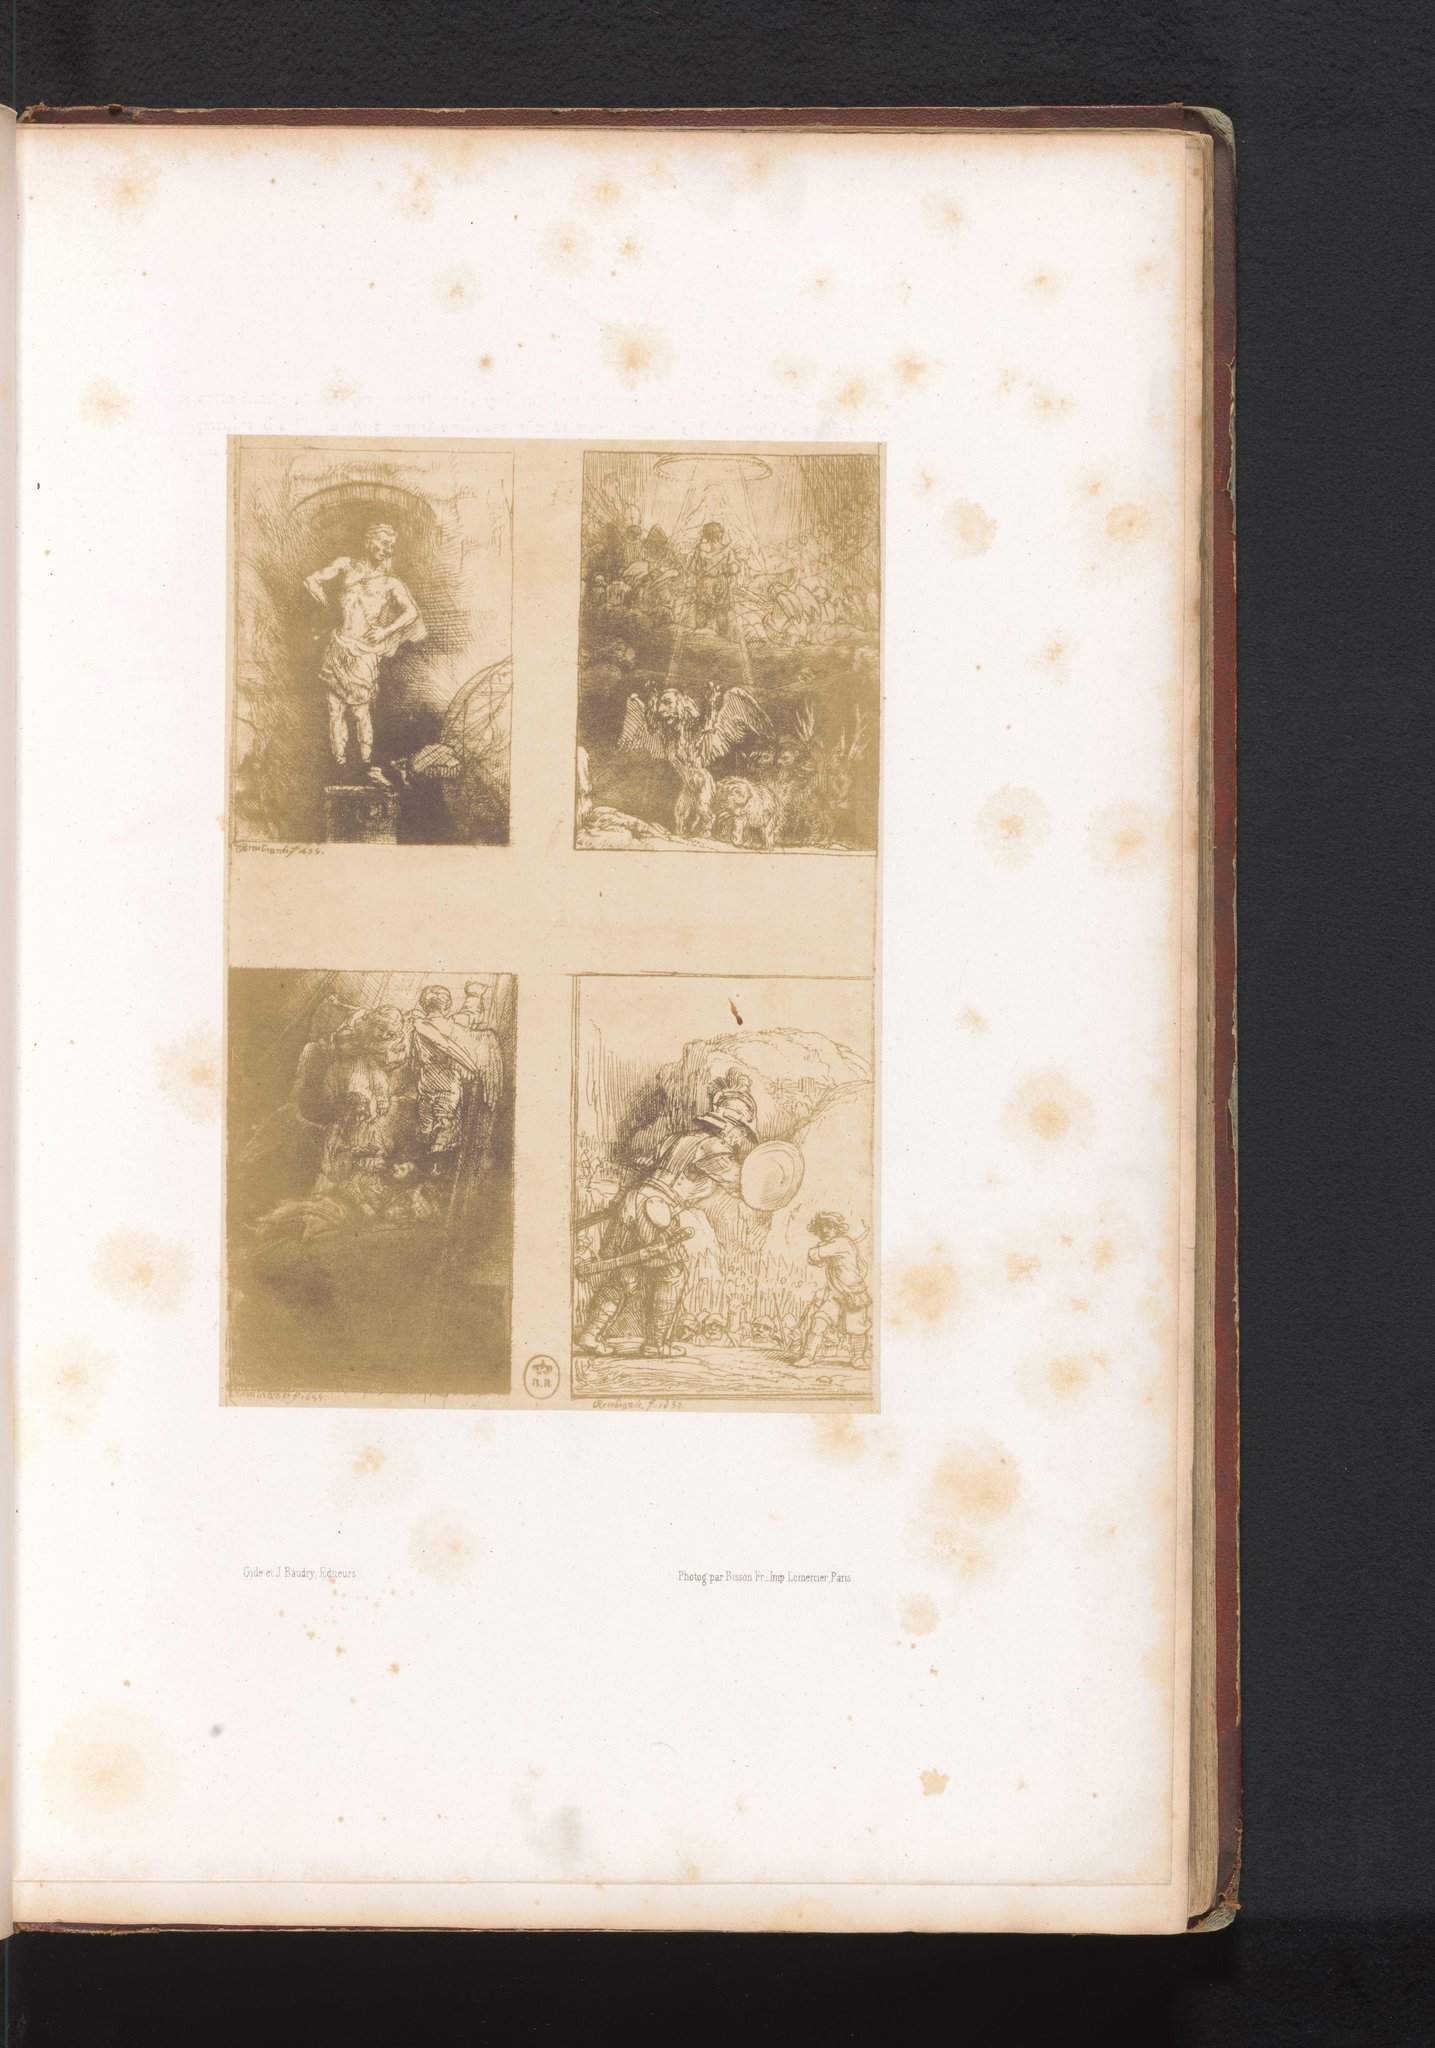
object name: page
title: Fotoreproducties van vier etsen voor een Spaans boek door Rembrandt van Rijn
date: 1848-1853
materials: photographic support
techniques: salted paper print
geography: paris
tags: griffin (lion/eagle); 'griffo' (ripa), angels